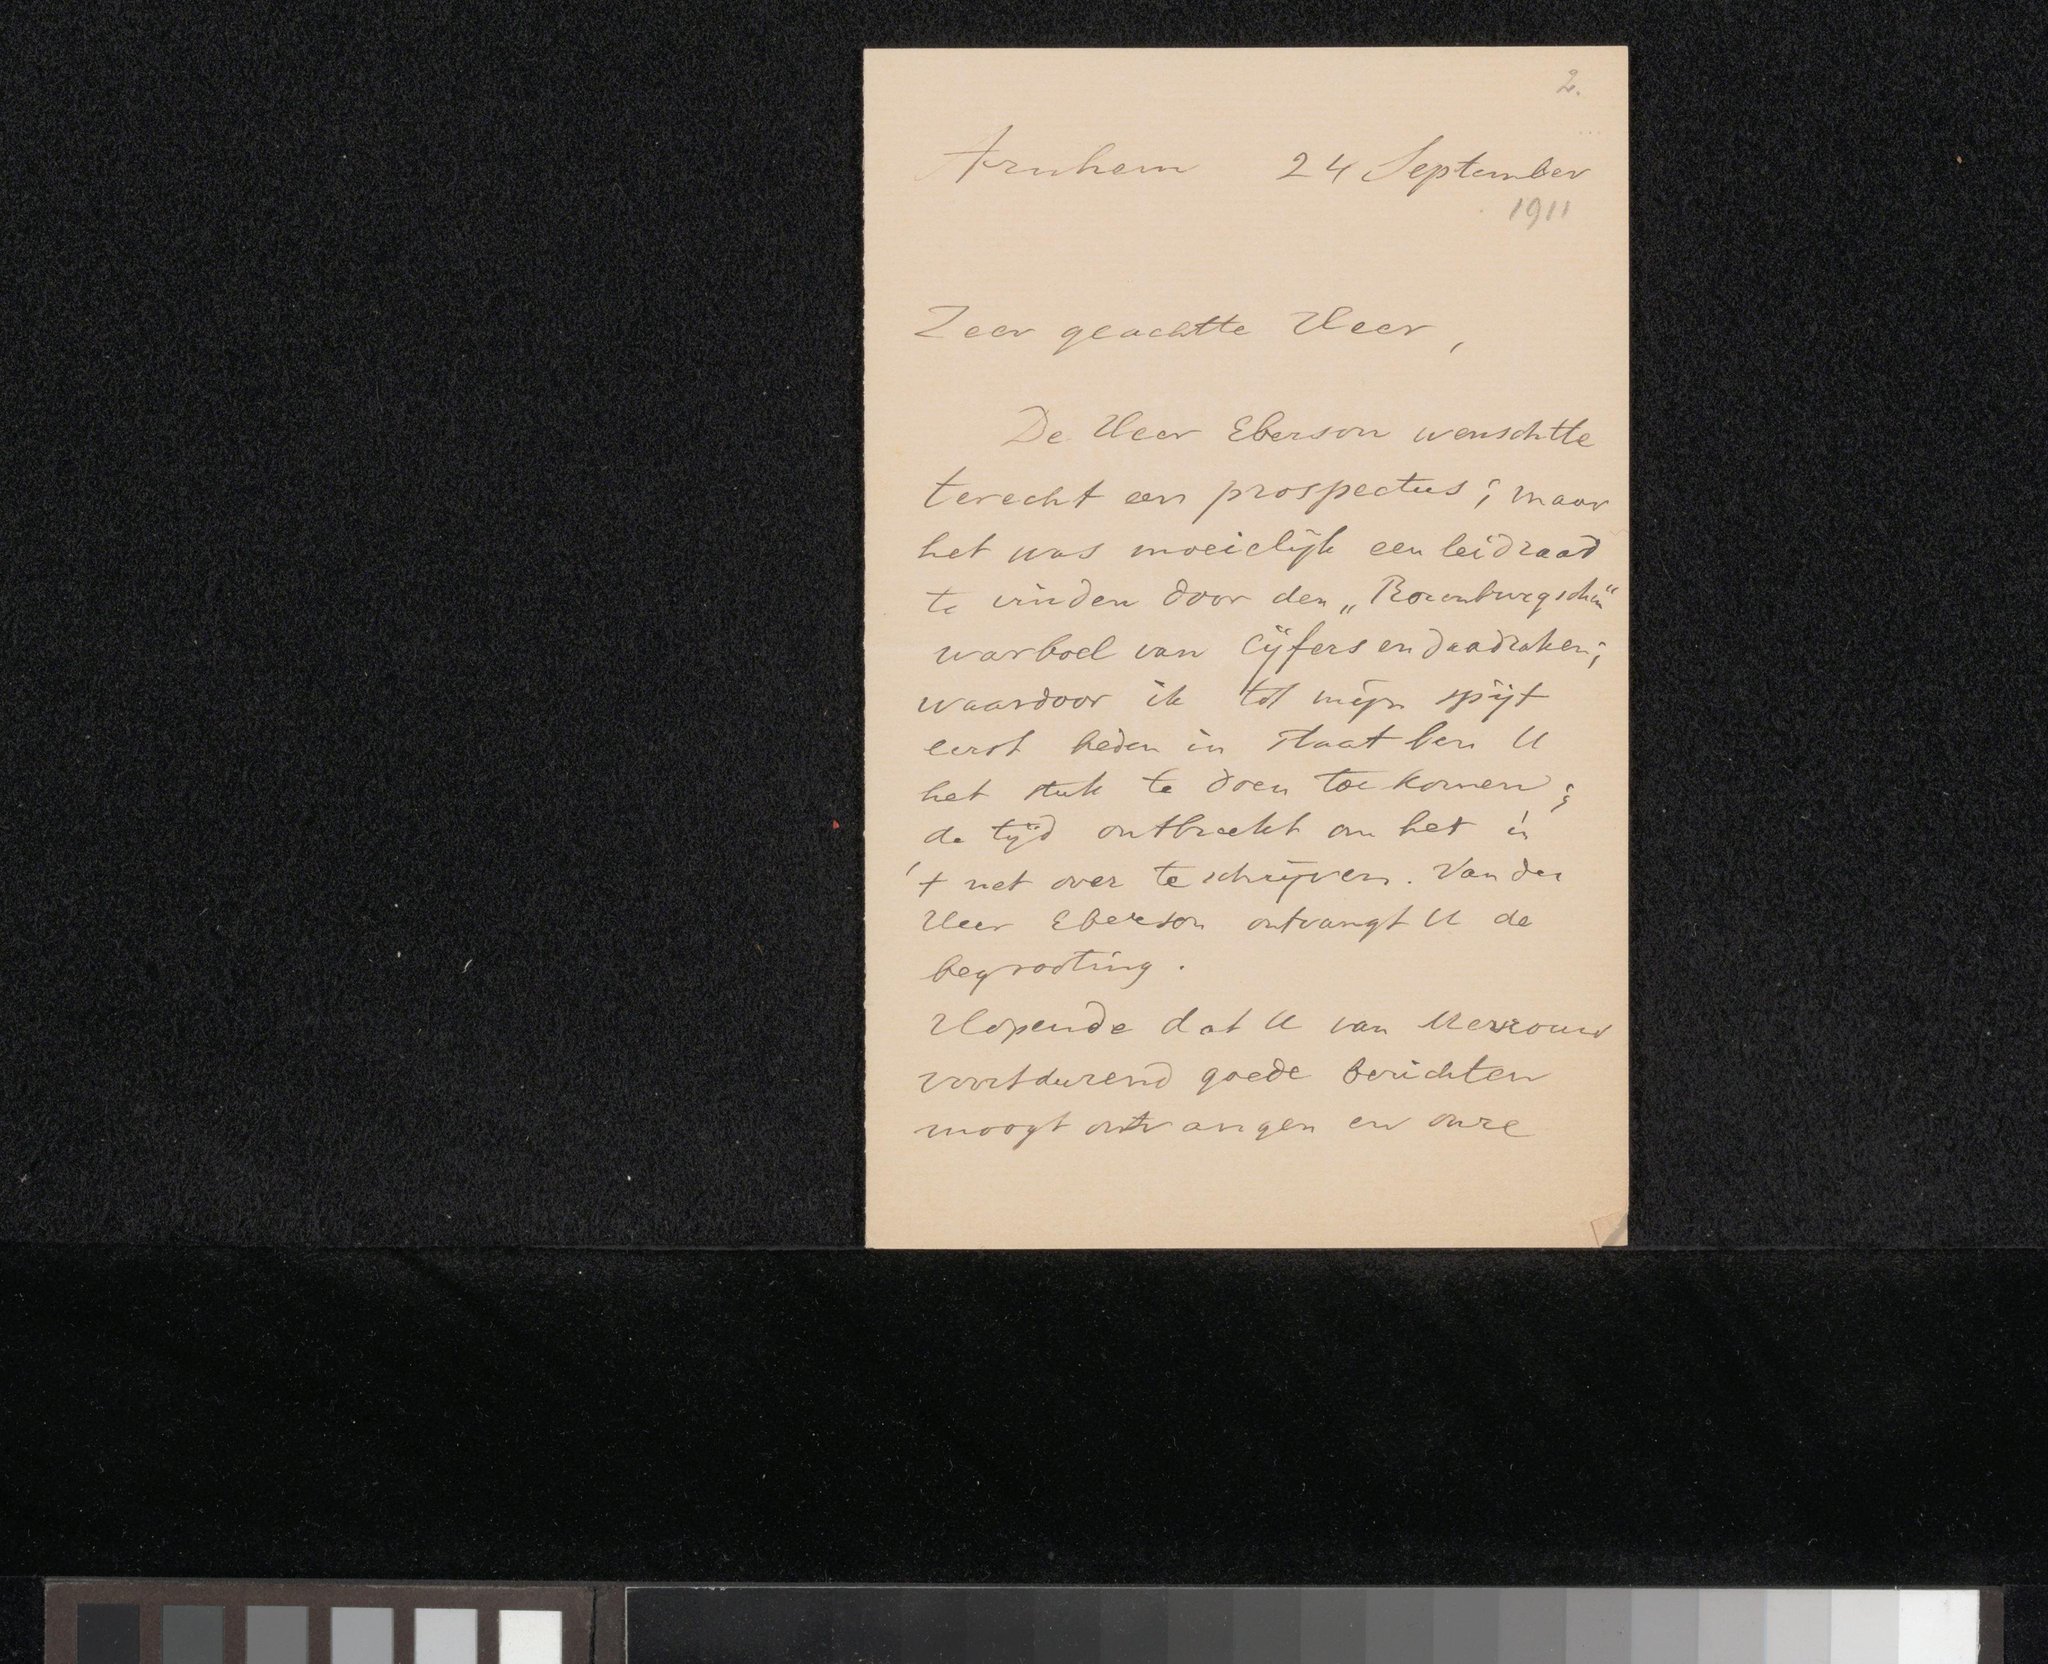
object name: letter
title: Brief aan Pieter Haverkorn van Rijsewijk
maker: theo colenbrander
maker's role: draughtsman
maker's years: 1841-1930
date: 1851-1915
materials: ink, paper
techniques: pen, writing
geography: arnhem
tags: w.g. eberson, pieter haverkorn van rijsewijk, money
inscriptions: watermark, collector's mark: ‘RPK’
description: Brief gedateerd 24 September door schrijver, met toevoeging 1911 in latere hand.